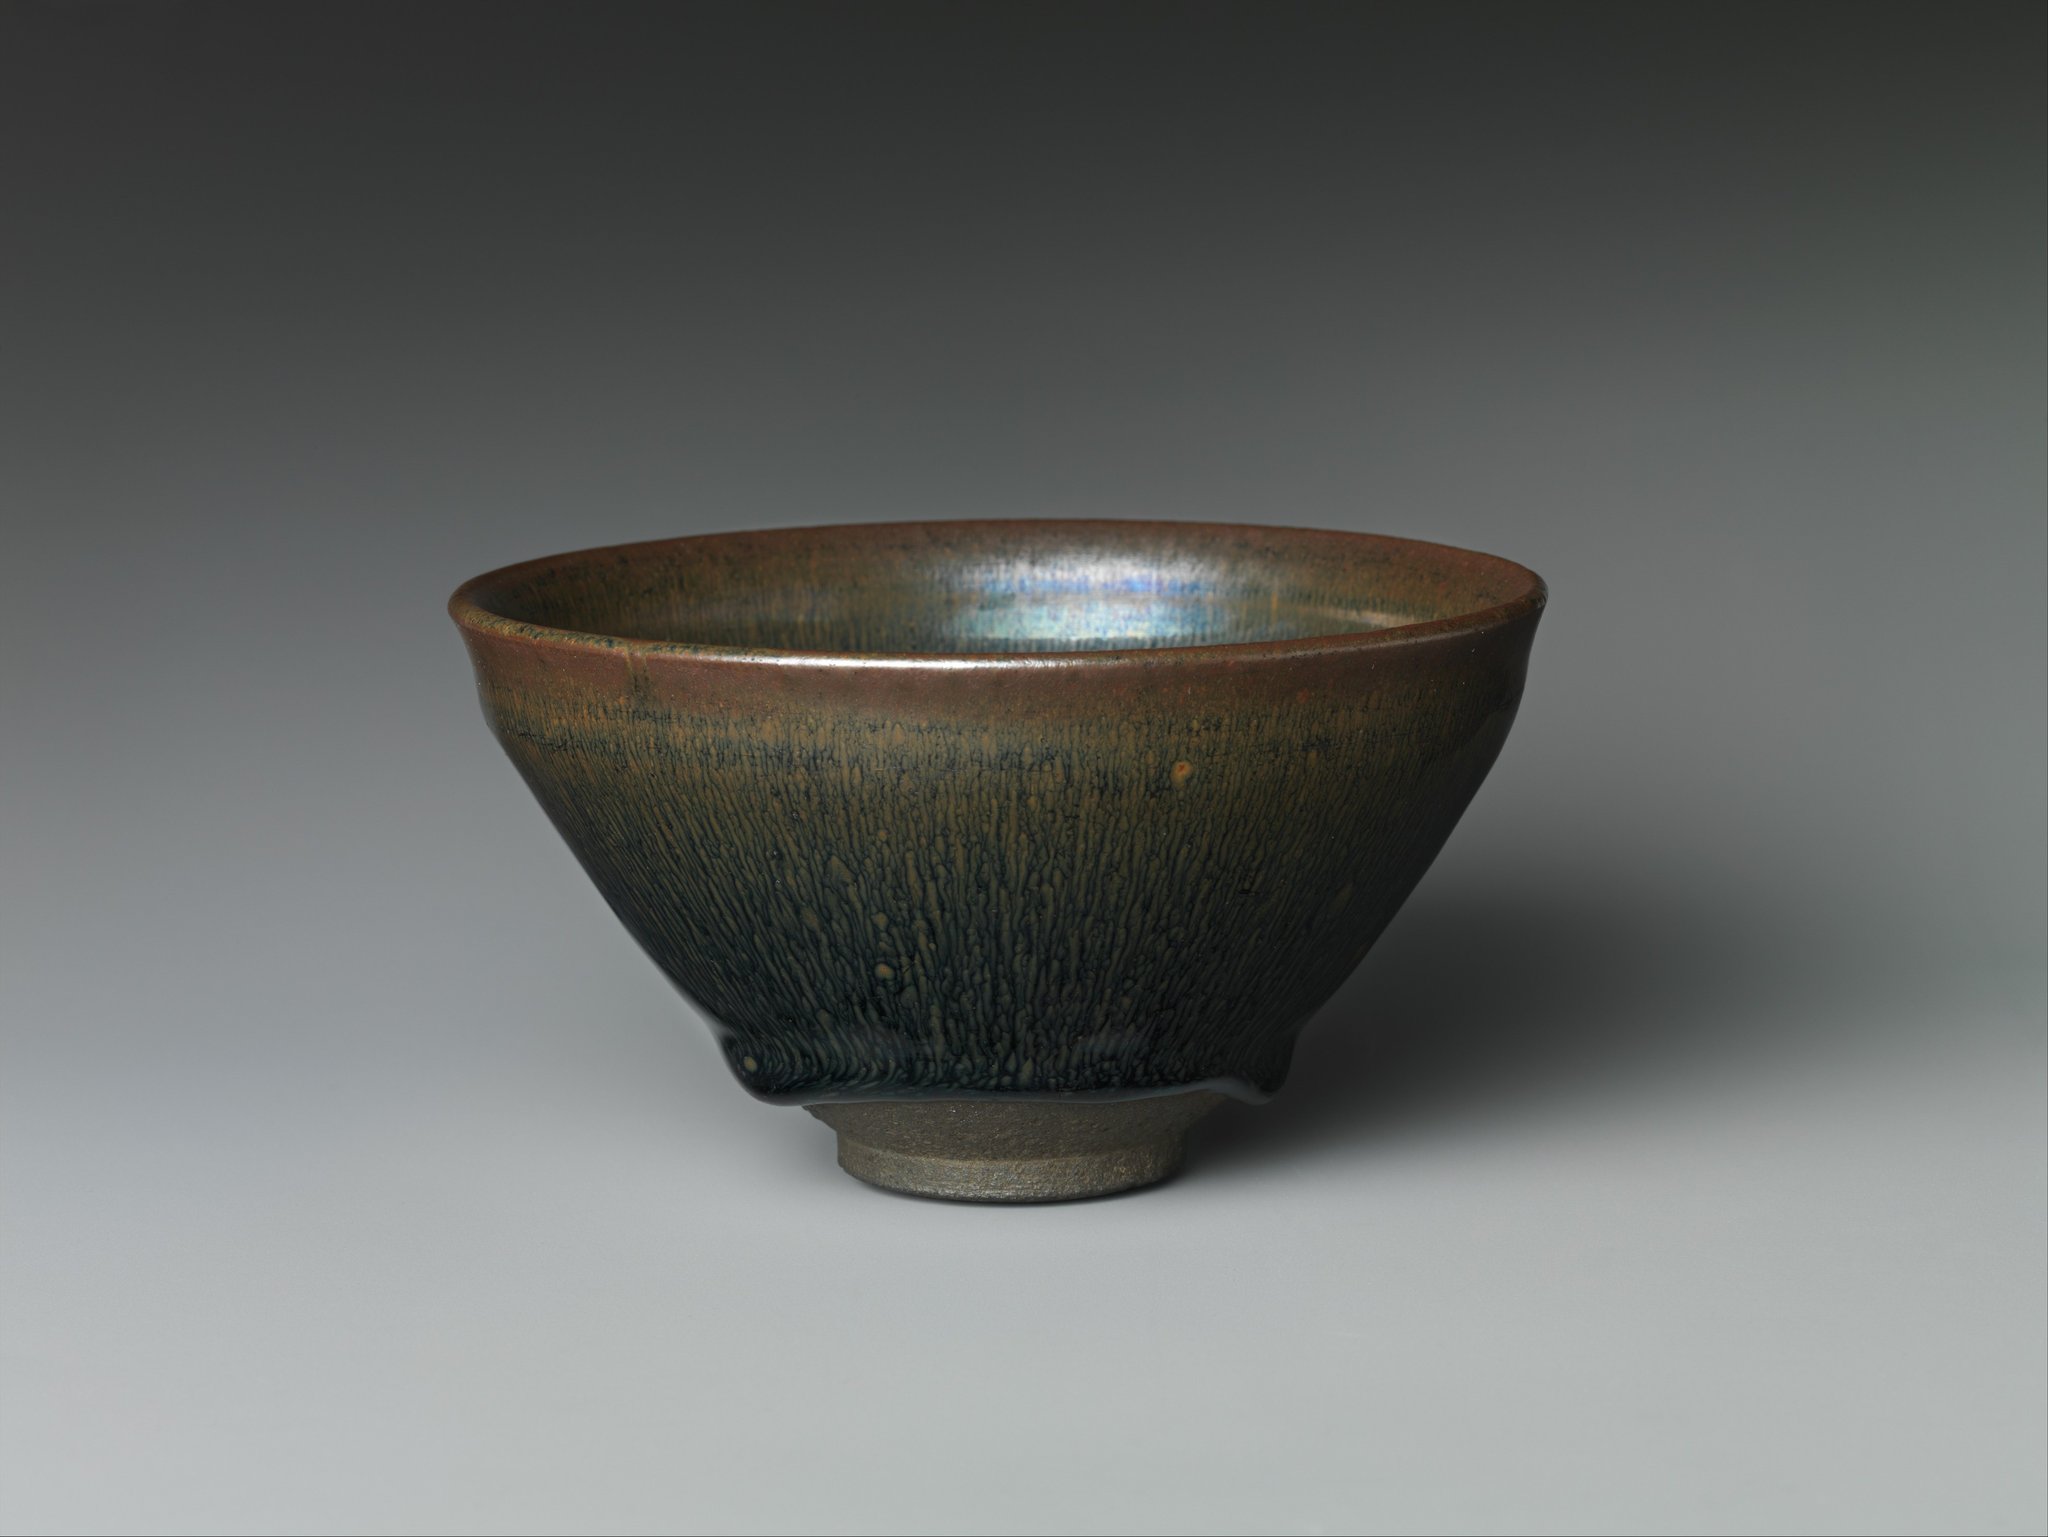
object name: tea bowl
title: Tea Bowl with “Hare’s-Fur” Glaze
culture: chinese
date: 1101-1200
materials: glaze, iron, stoneware